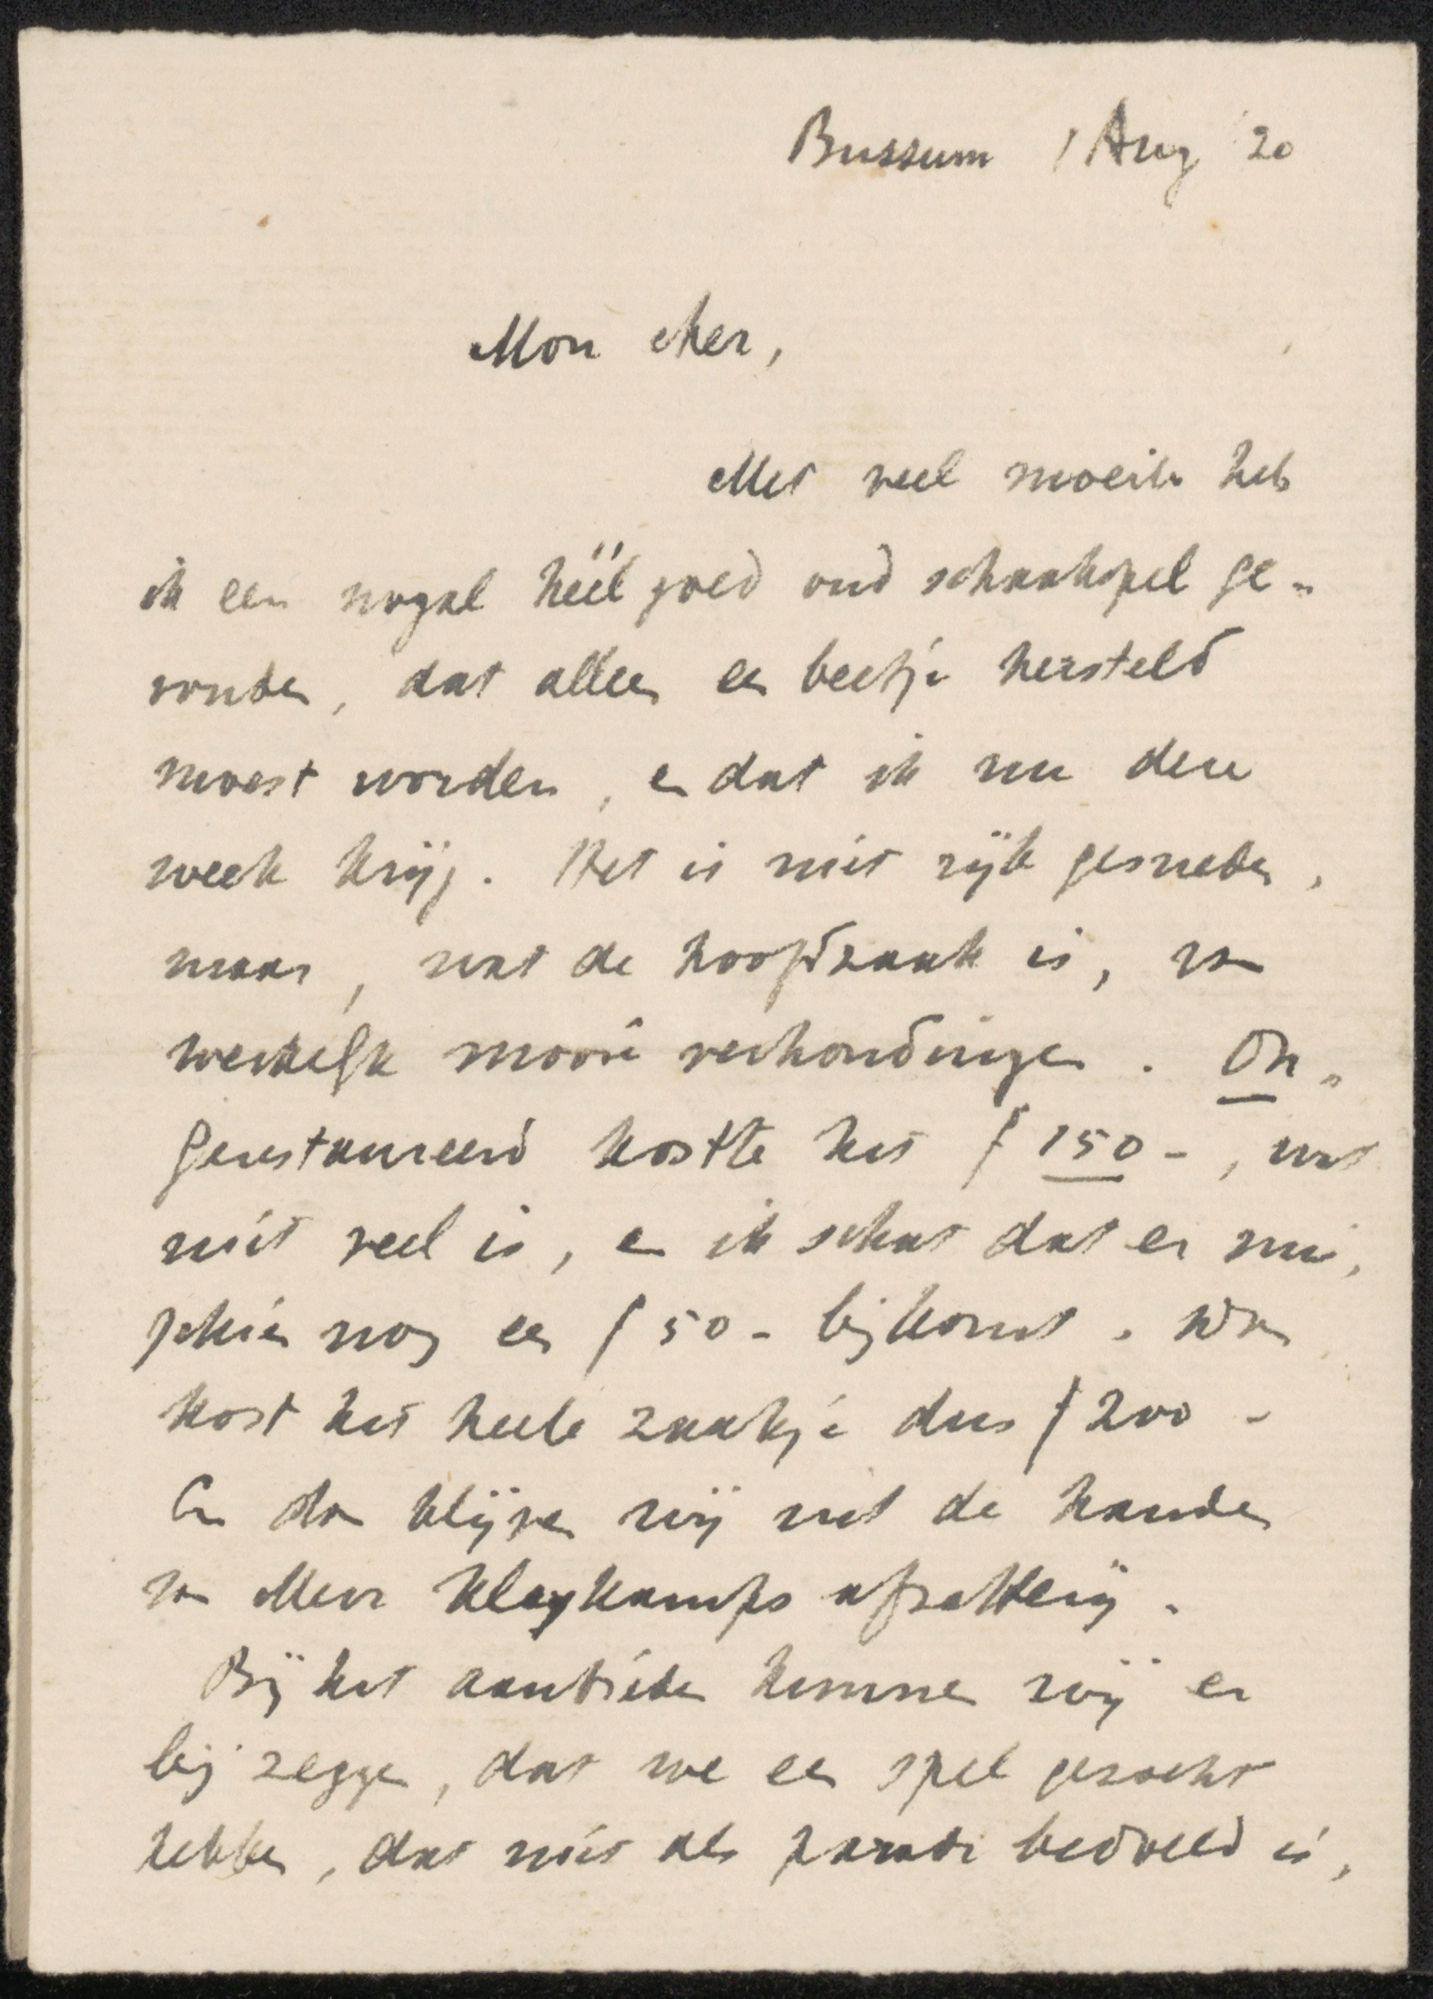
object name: letter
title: Brief aan Isaac Israels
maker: jan veth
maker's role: designer, draughtsman, painter, print maker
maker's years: 1864-1925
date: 1920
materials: ink, paper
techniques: pen, writing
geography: bussum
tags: isaac israels, theo nieuwenhuis, the hague, willem kloos, chap van deventer, amsterdam, hein boeken, middelburg, albertine draaijer-de haas, batavia, applied arts, arts and crafts; industrial design, historical persons (portraits and scenes from the life), money, rotterdam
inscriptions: collector's mark: ‘RPK’